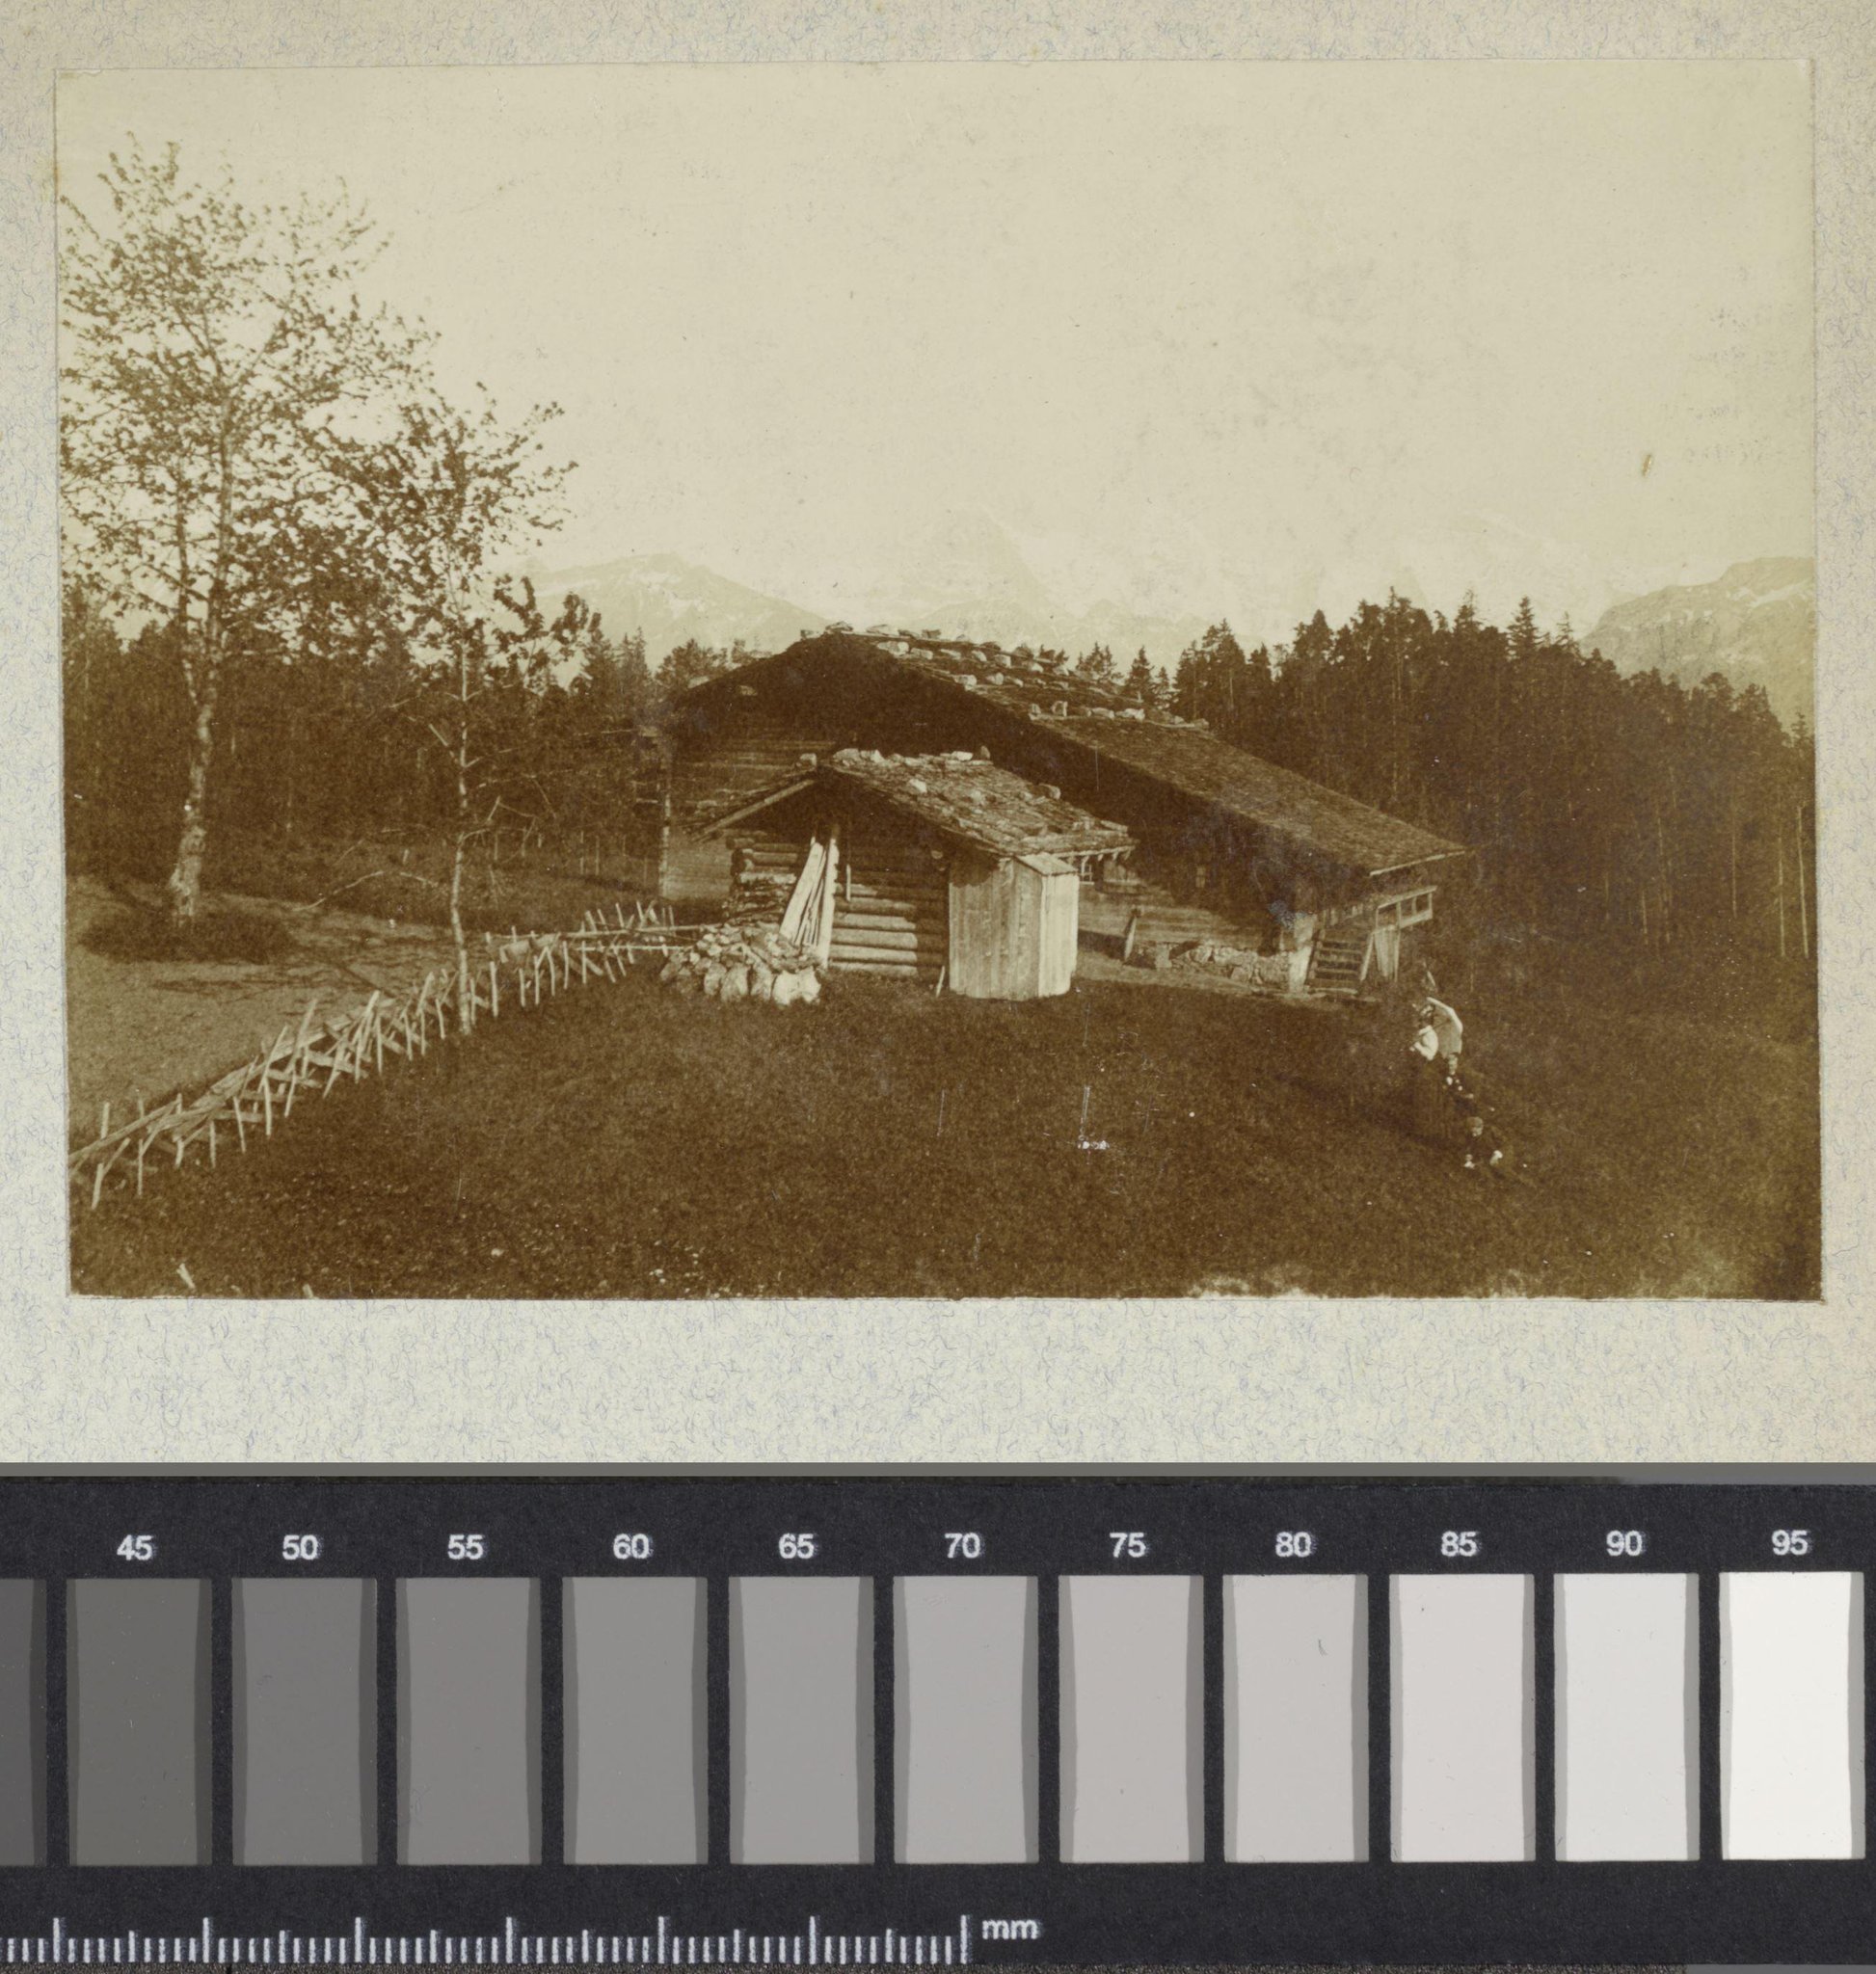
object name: photograph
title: Vakantie in Zwitserland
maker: andries augustus boom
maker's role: amateurfotograaf, handelaar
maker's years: 1878-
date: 1897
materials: photographic support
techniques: photography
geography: switzerland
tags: andries augustus boom, switzerland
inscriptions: date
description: Vakantie in Vitznau, Zwitserland. Onderdeel van het fotoalbum van de familie Boom-Gonggrijp in Suriname en Curaçao.